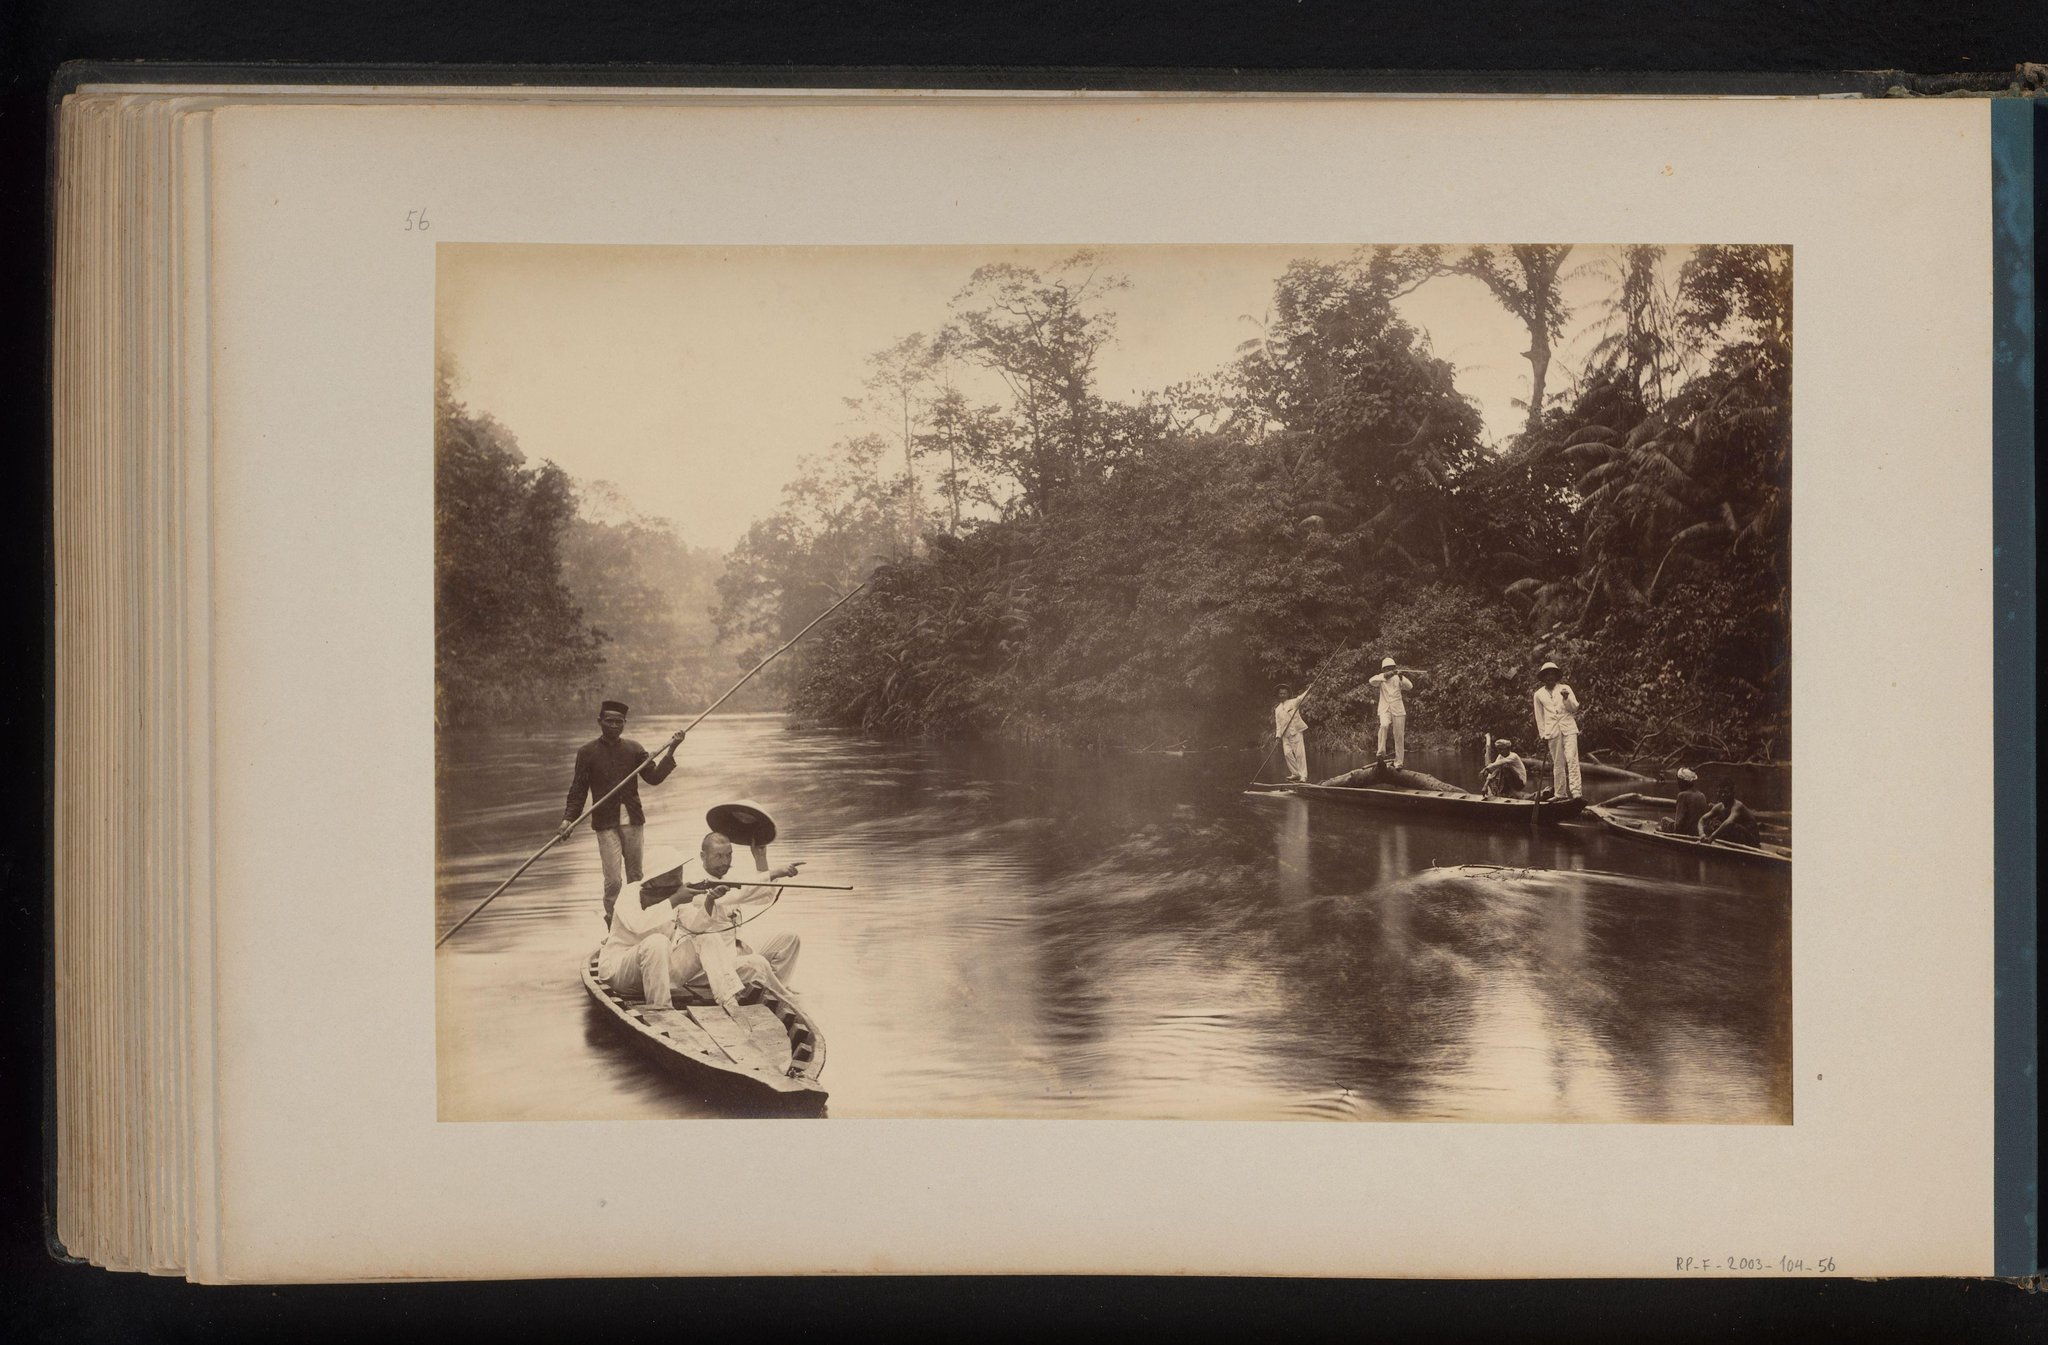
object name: album leaf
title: Crocodile hunting party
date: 1890-1900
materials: cardboard, photographic support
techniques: albumen print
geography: sumatra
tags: crocodiles: crocodile, river (+ landscape with figures, staffage), hunt ~ other animals, sumatra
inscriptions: number: ‘56’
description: In de lijst van afbeeldingen wordt deze foto beschreven met de woorden "Flusspartie in Bedagei".